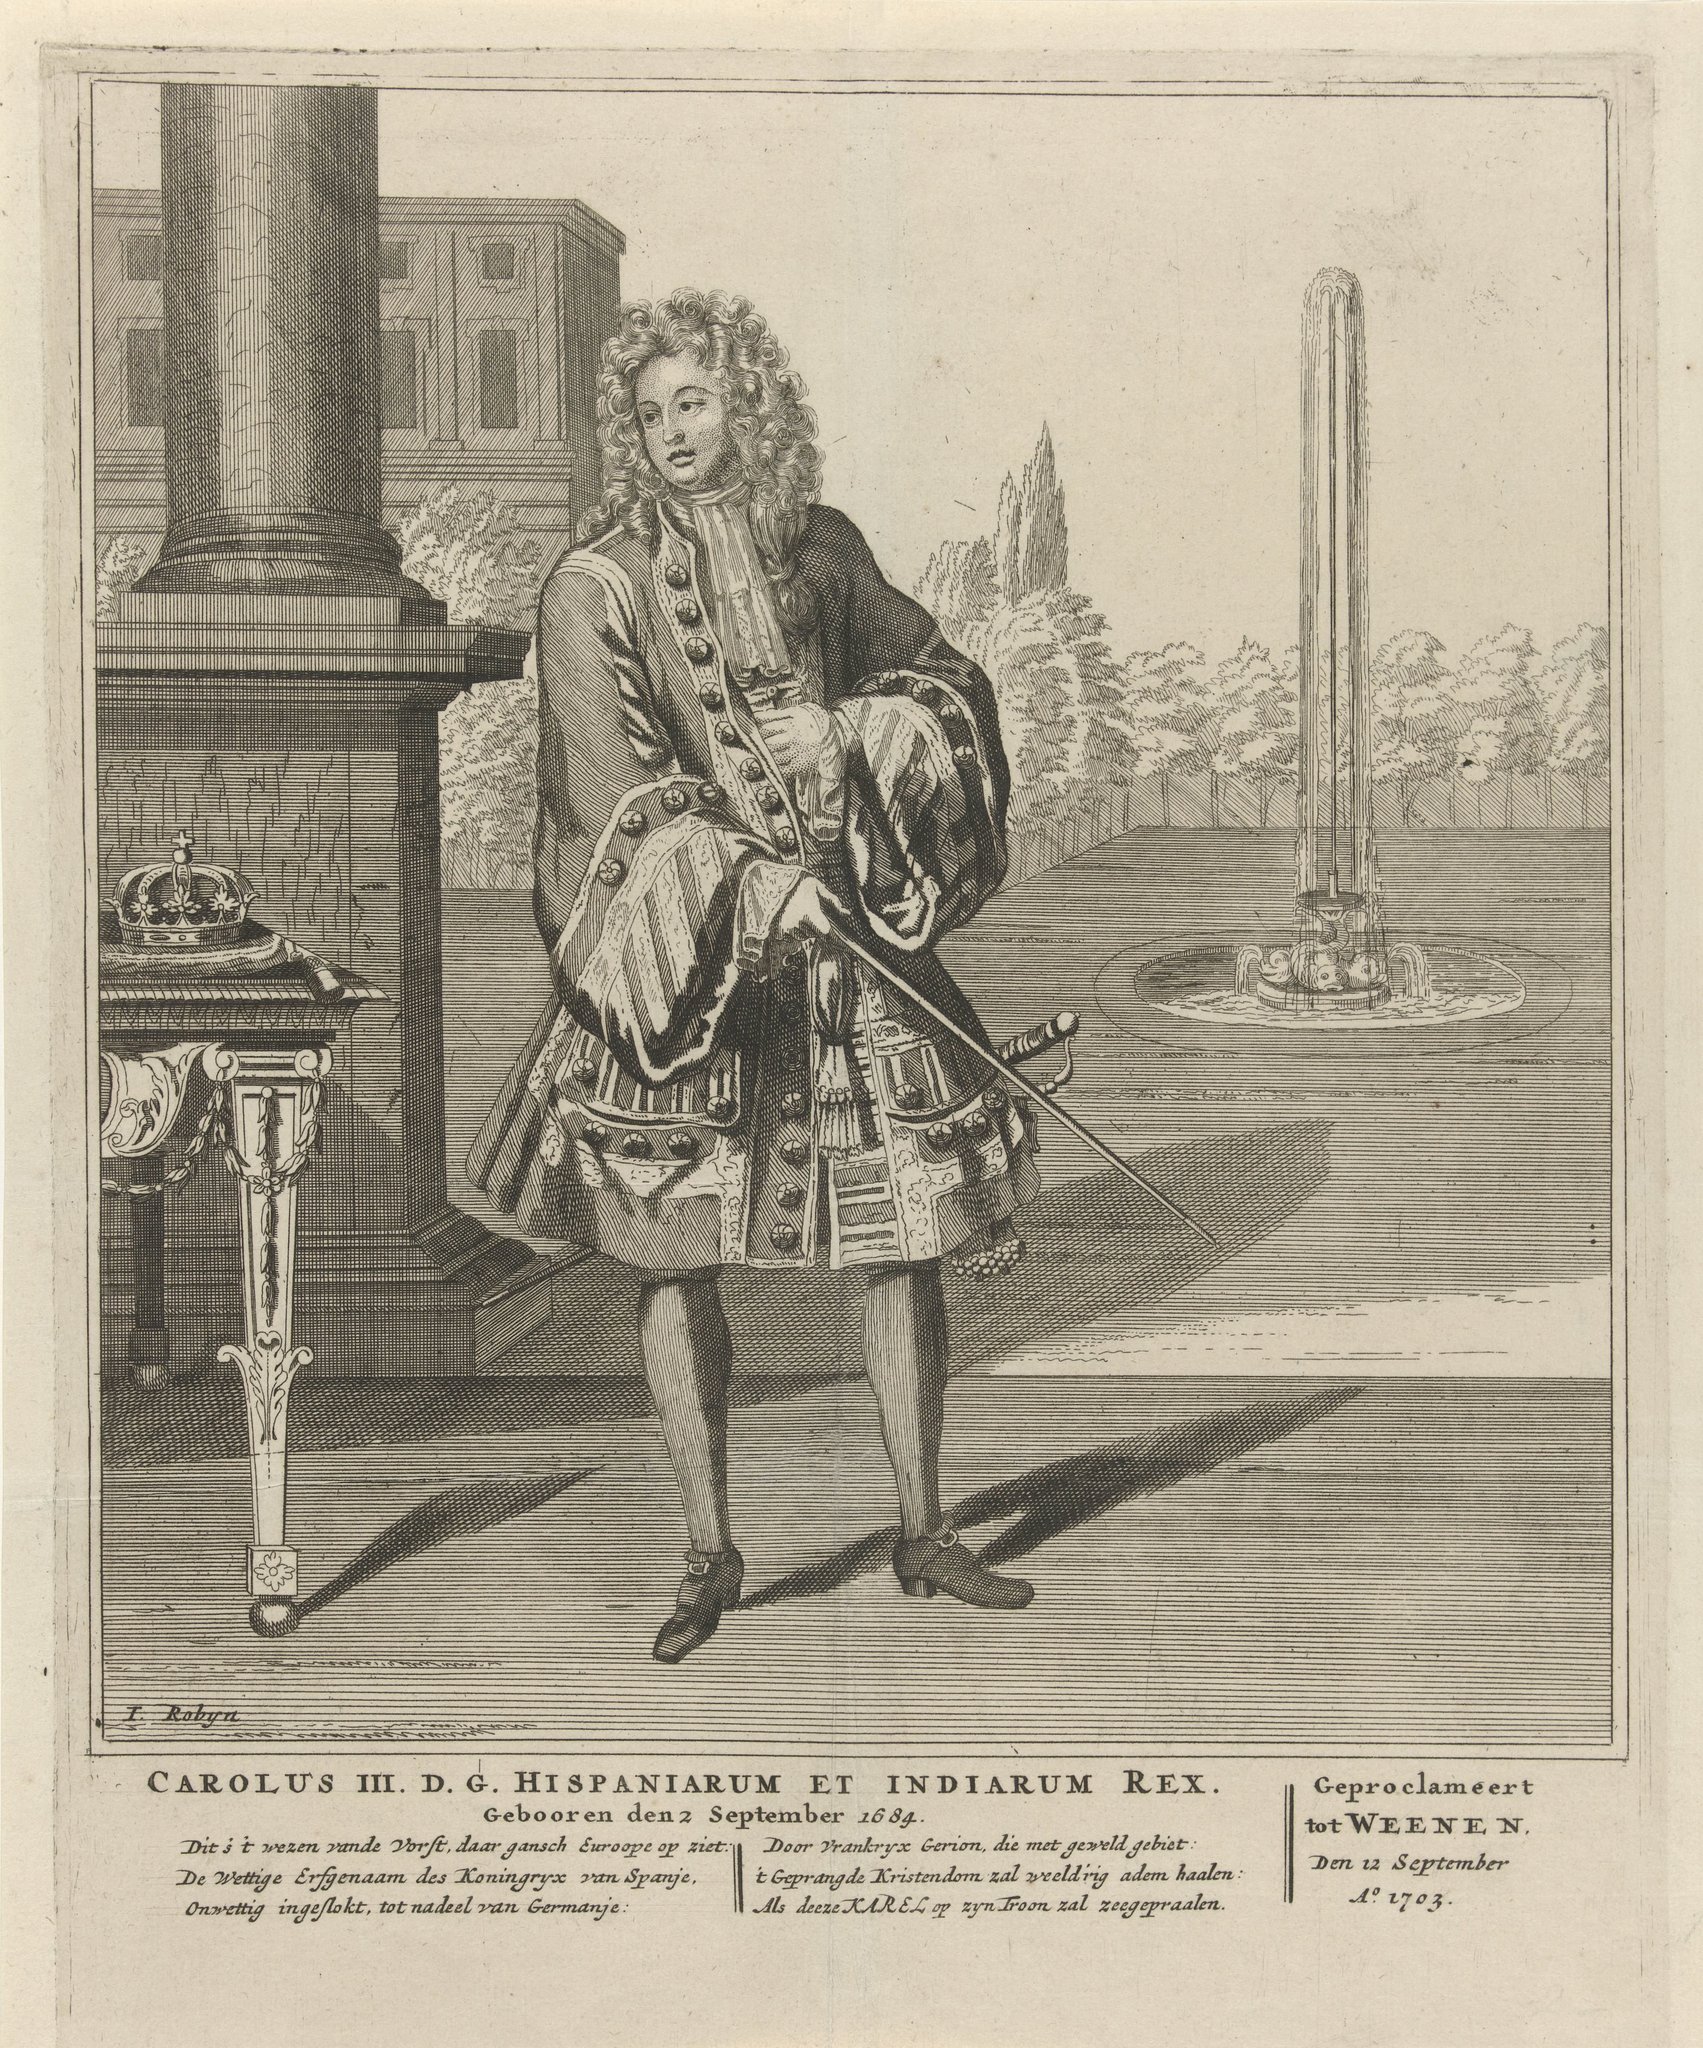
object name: print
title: Portret van keizer Karel VI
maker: jacobus robijn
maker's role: print maker, publisher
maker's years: -1707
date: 1703-1707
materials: paper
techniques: etching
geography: northern netherlands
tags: vienna, charles vi (holy roman emperor)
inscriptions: collector's mark: Lugt 2228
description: Portret van aartshertog Karel van Oostenrijk, die zichzelf tijdens de Spaanse Successieoorlog beschouwde en benoemde als koning Karel III van Spanje. Vanaf 1711 tot 1740 was hij keizer van het Heilige Roomse Rijk. Hij staat voor een fontein, links van hem een tafel met een koningskroon. In de marge zijn naam (Karel de derde in gods gratie koning van Spanje en (Zuid-) Amerika) en een gedicht.